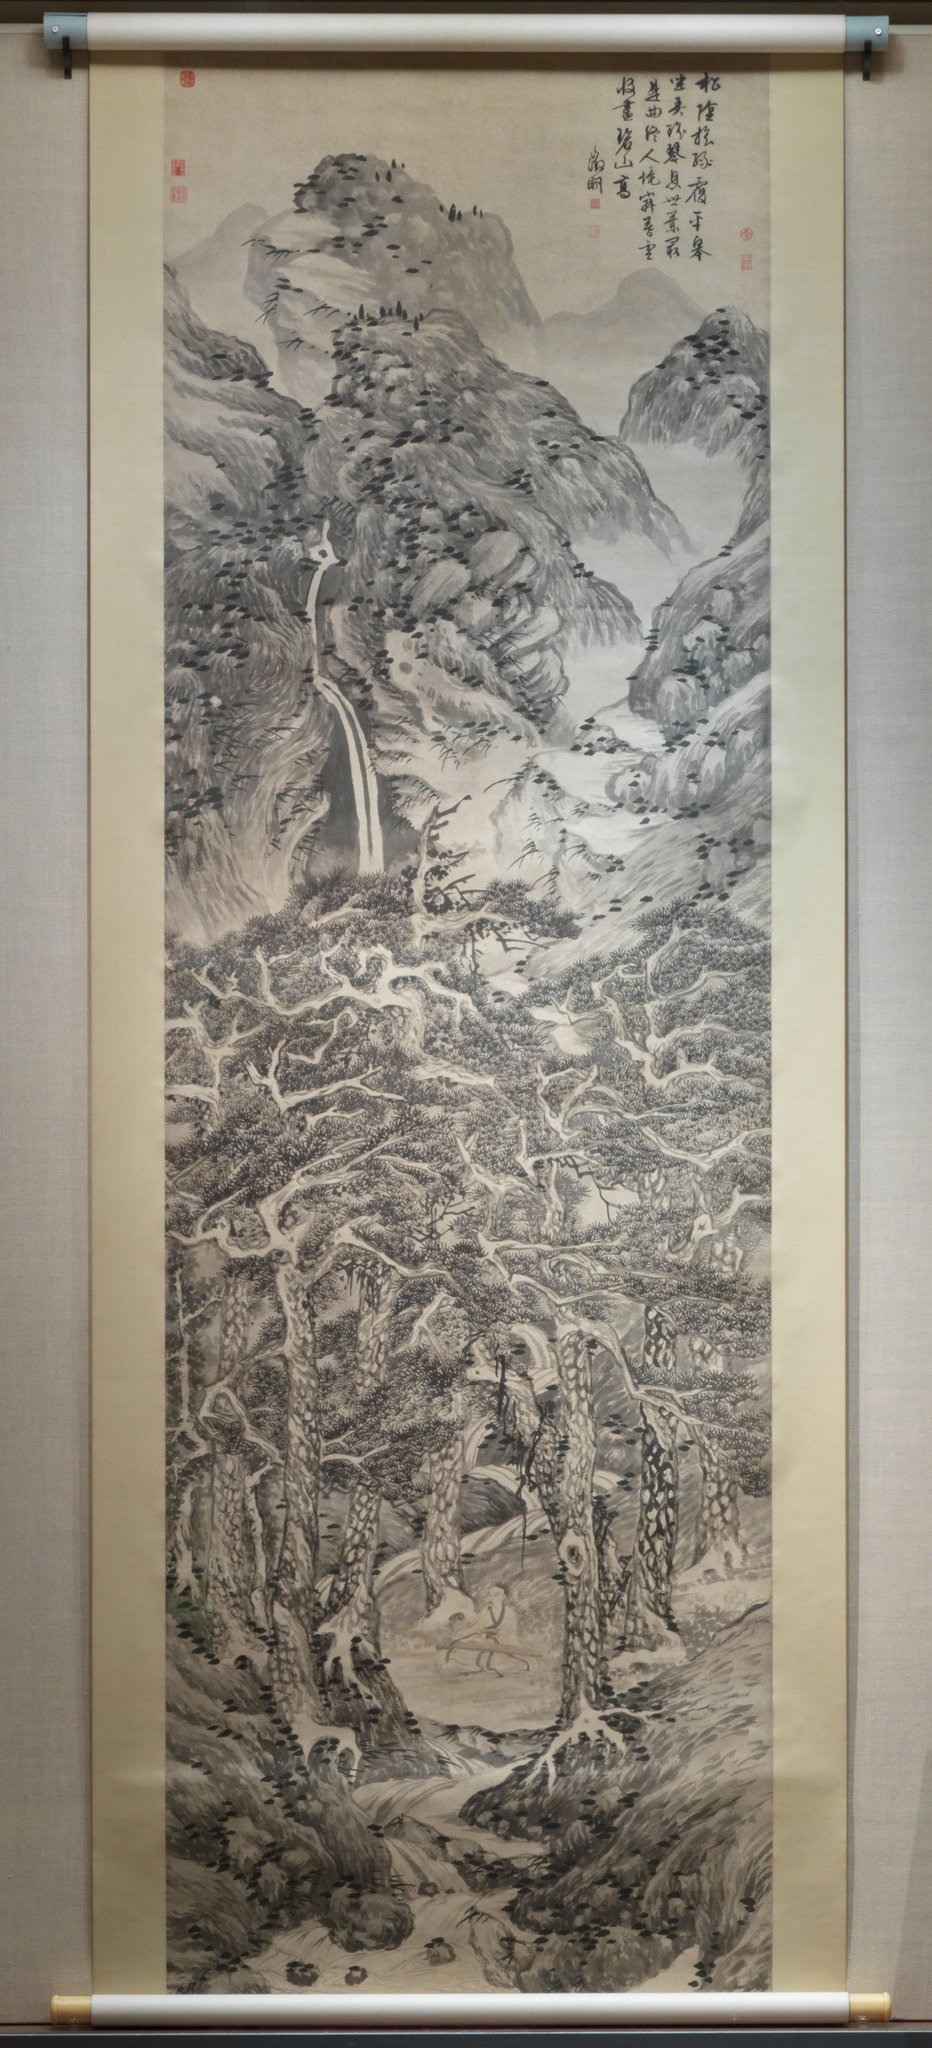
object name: hanging scroll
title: Recluse playing the zither in a pine grove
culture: chinese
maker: wen zhengming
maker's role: artist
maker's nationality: chinese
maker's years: 1470-1559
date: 1540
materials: ink, paper